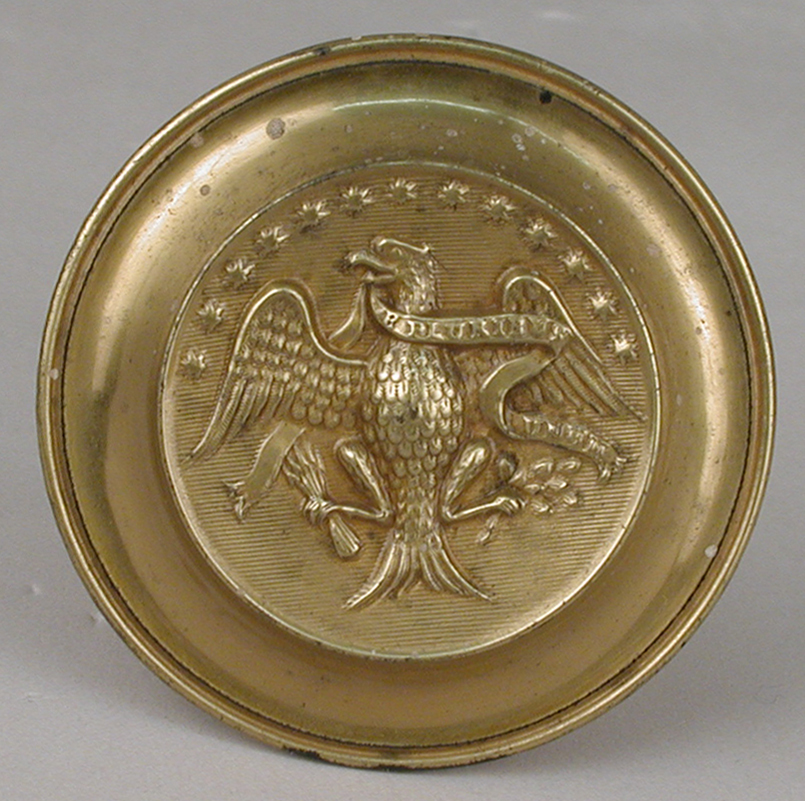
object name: curtain knob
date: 1700-1900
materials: brass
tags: eagles